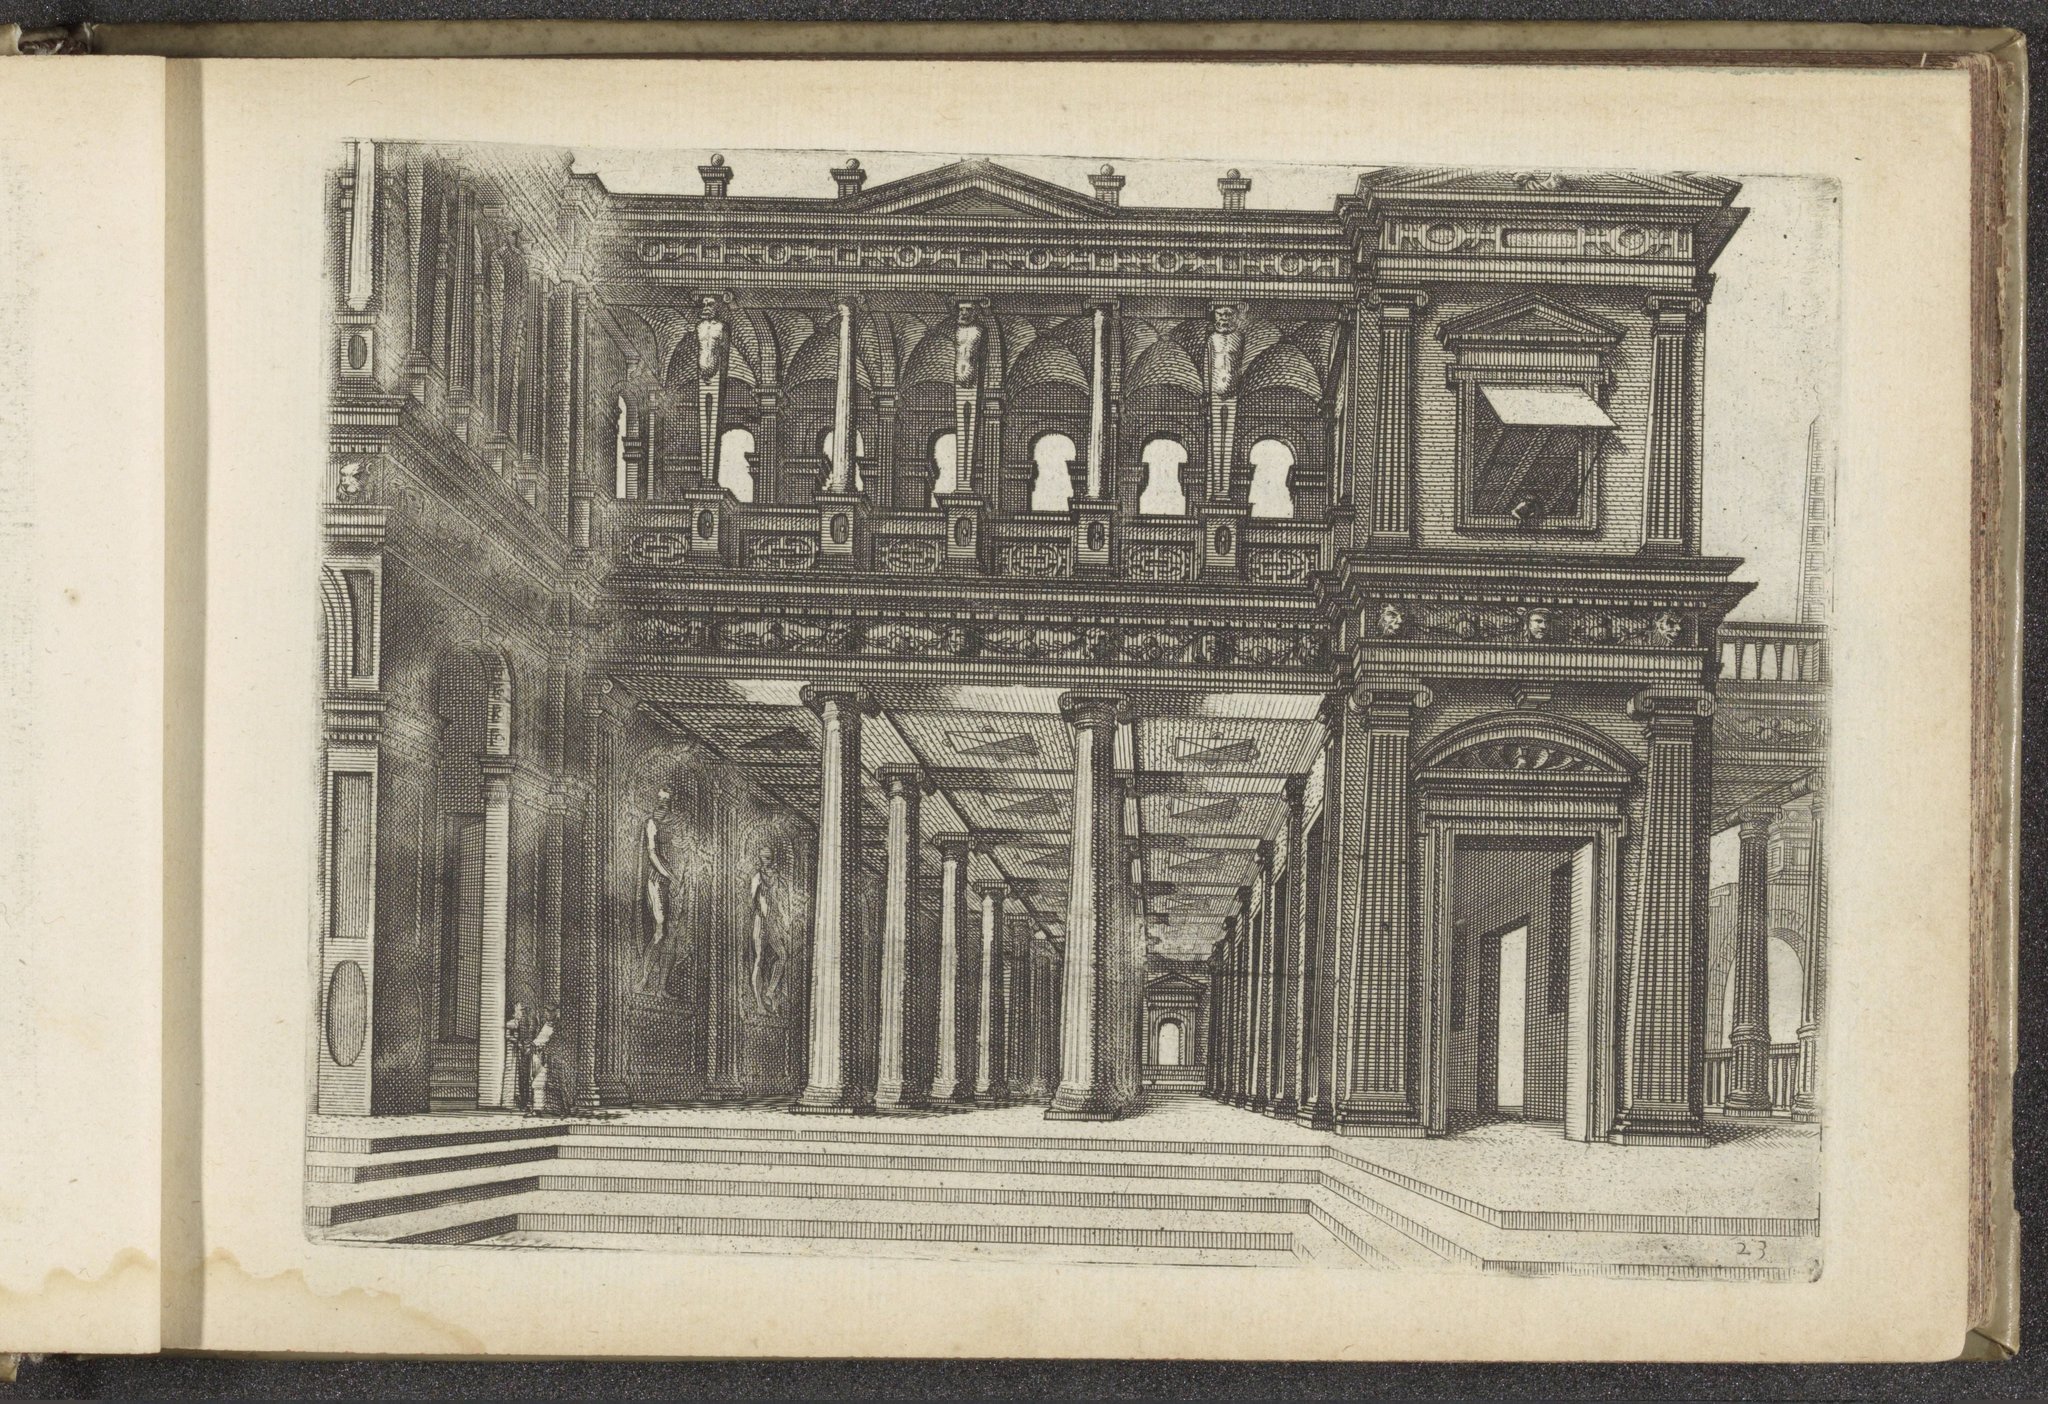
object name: album leaf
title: Variae Architecturae formae (...)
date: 1562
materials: paper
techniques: etching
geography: antwerp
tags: architectural representations in general, ionic order ~ architecture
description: Paleis met een open hal op de begane grond met zuilen van de Ionische orde. Op de eerste verdieping een colonnade. Deze prent maakt deel uit van een album.